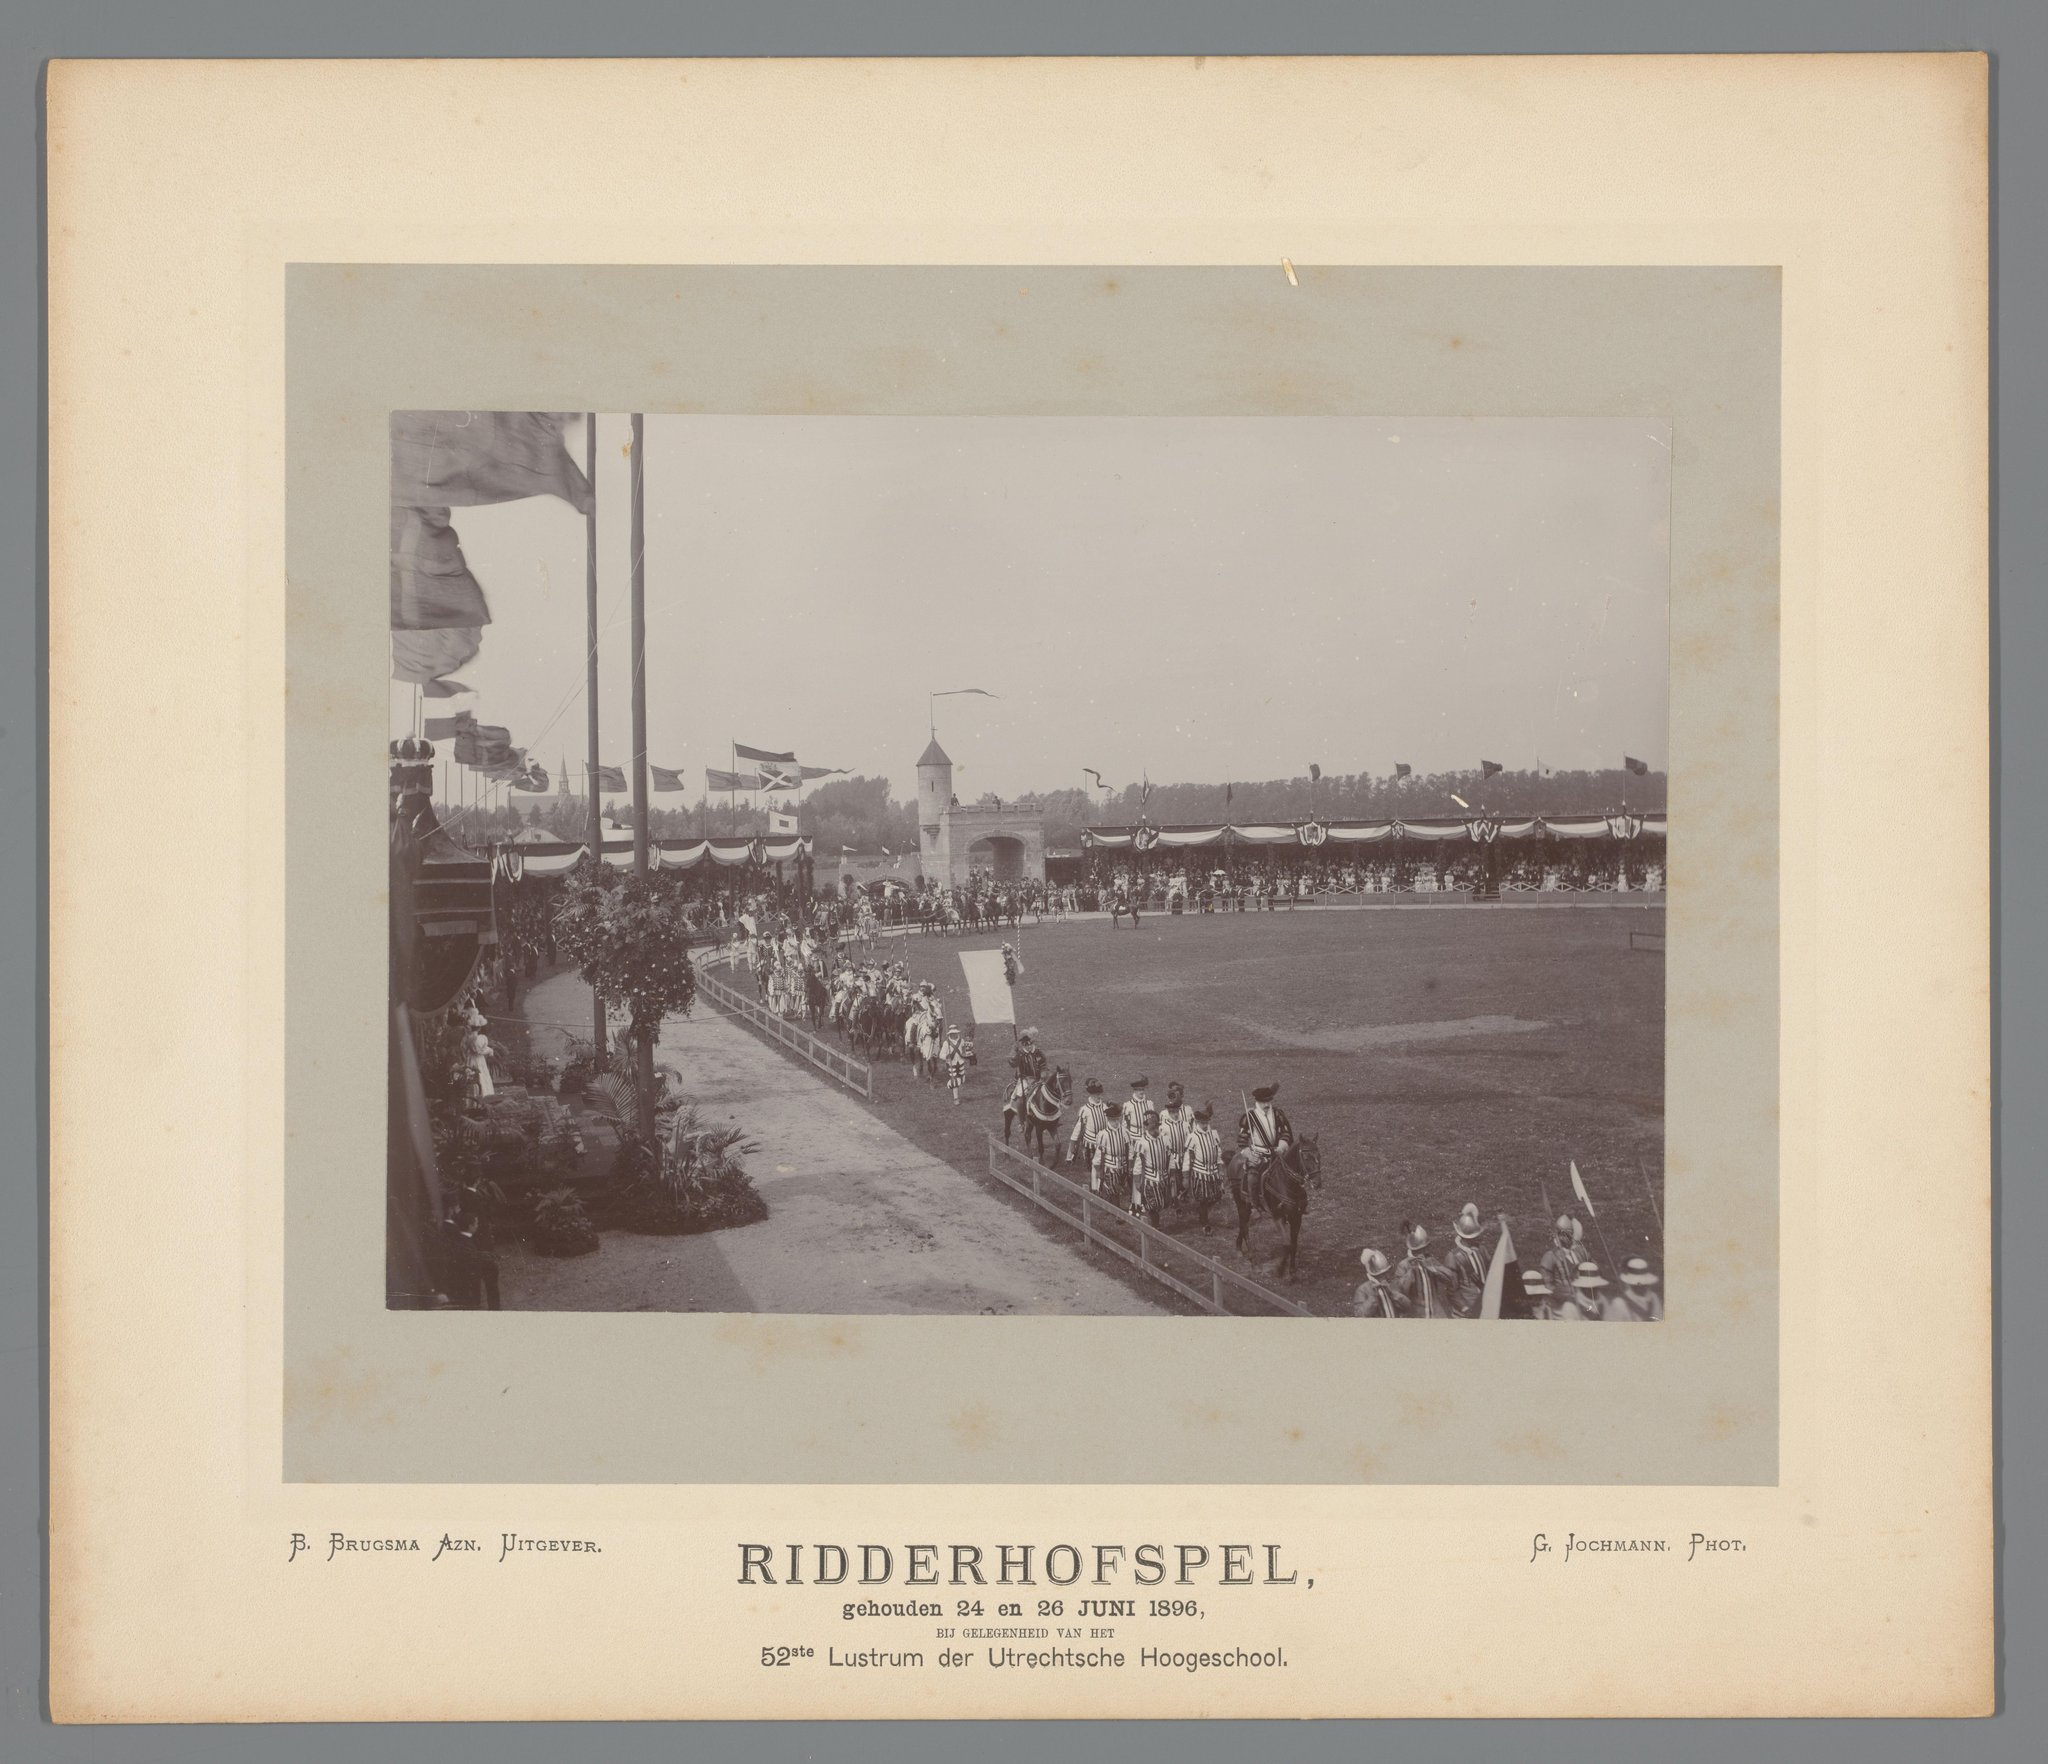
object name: photograph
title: Ridderhofspel, gehouden 24 en 26 juni 1896, bij gelegenheid van het 52ste Lustrum der Utrechtsche Hoogeschool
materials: cardboard, paper, photographic support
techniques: collodion silver print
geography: utrecht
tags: public festivities (+ parade, pageant, cavalcade ~ festive activities), (medieval) fighting contest, utrecht